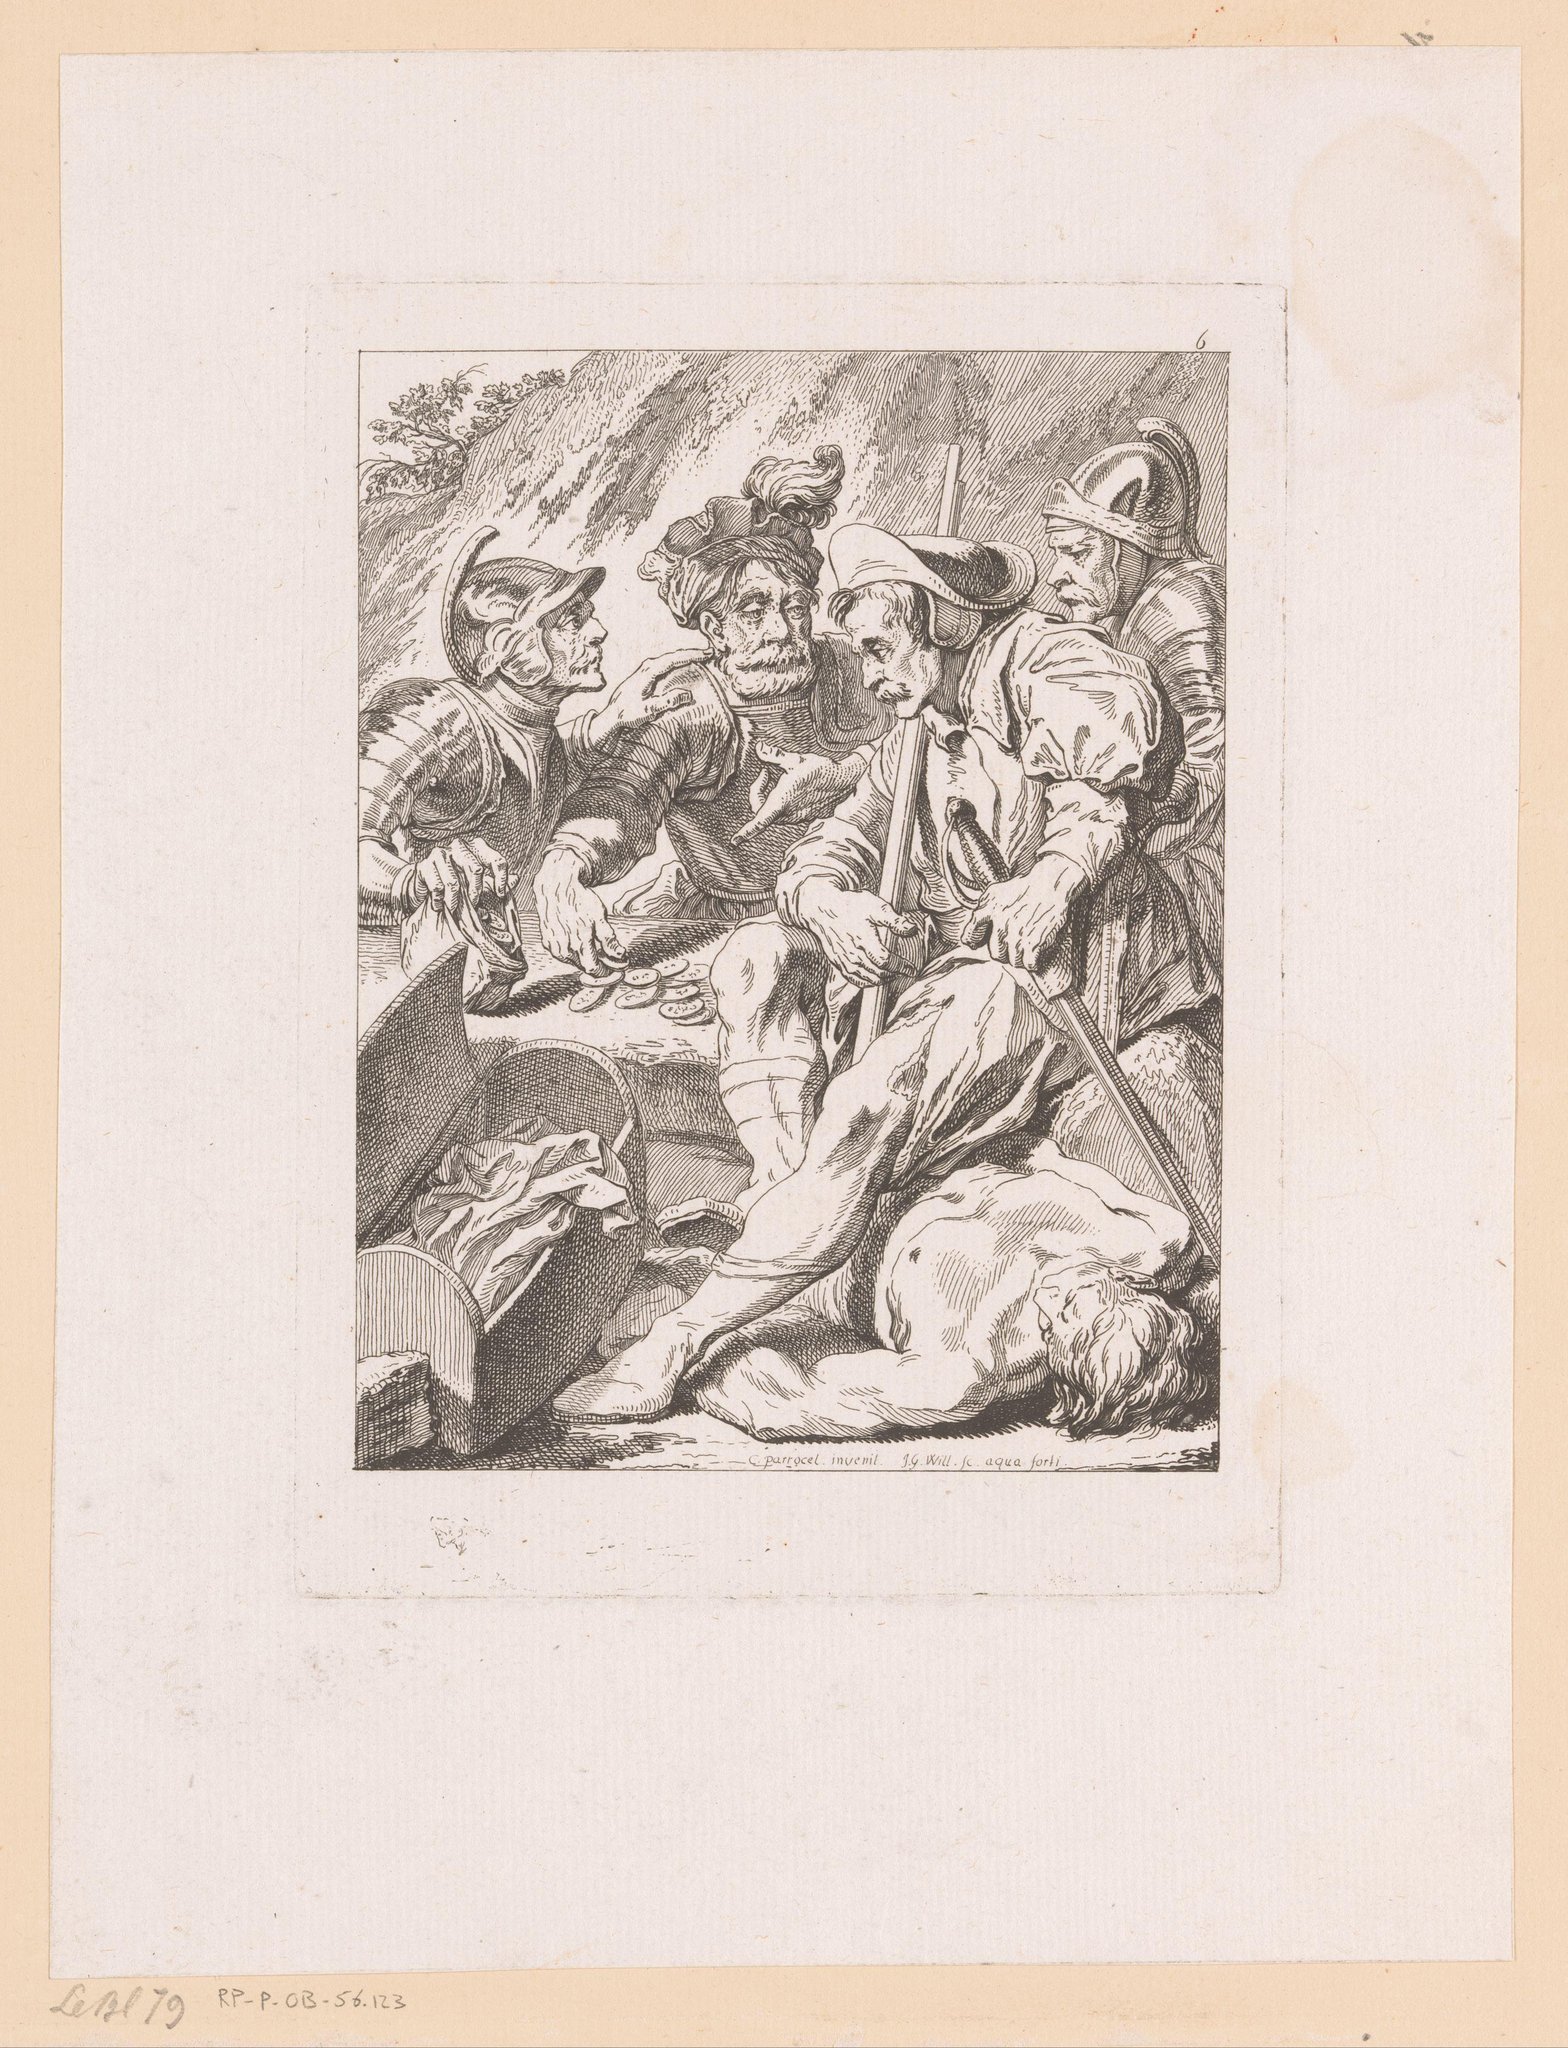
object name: print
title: Vier soldaten verdelen een buit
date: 1753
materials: paper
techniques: etching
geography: paris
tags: purse, money-bag, the soldier; the soldier's life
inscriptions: collector's mark: Lugt 240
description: Deze prent maakt deel uit van een serie van ten minste twaalf prenten met voorstellingen van soldaten.